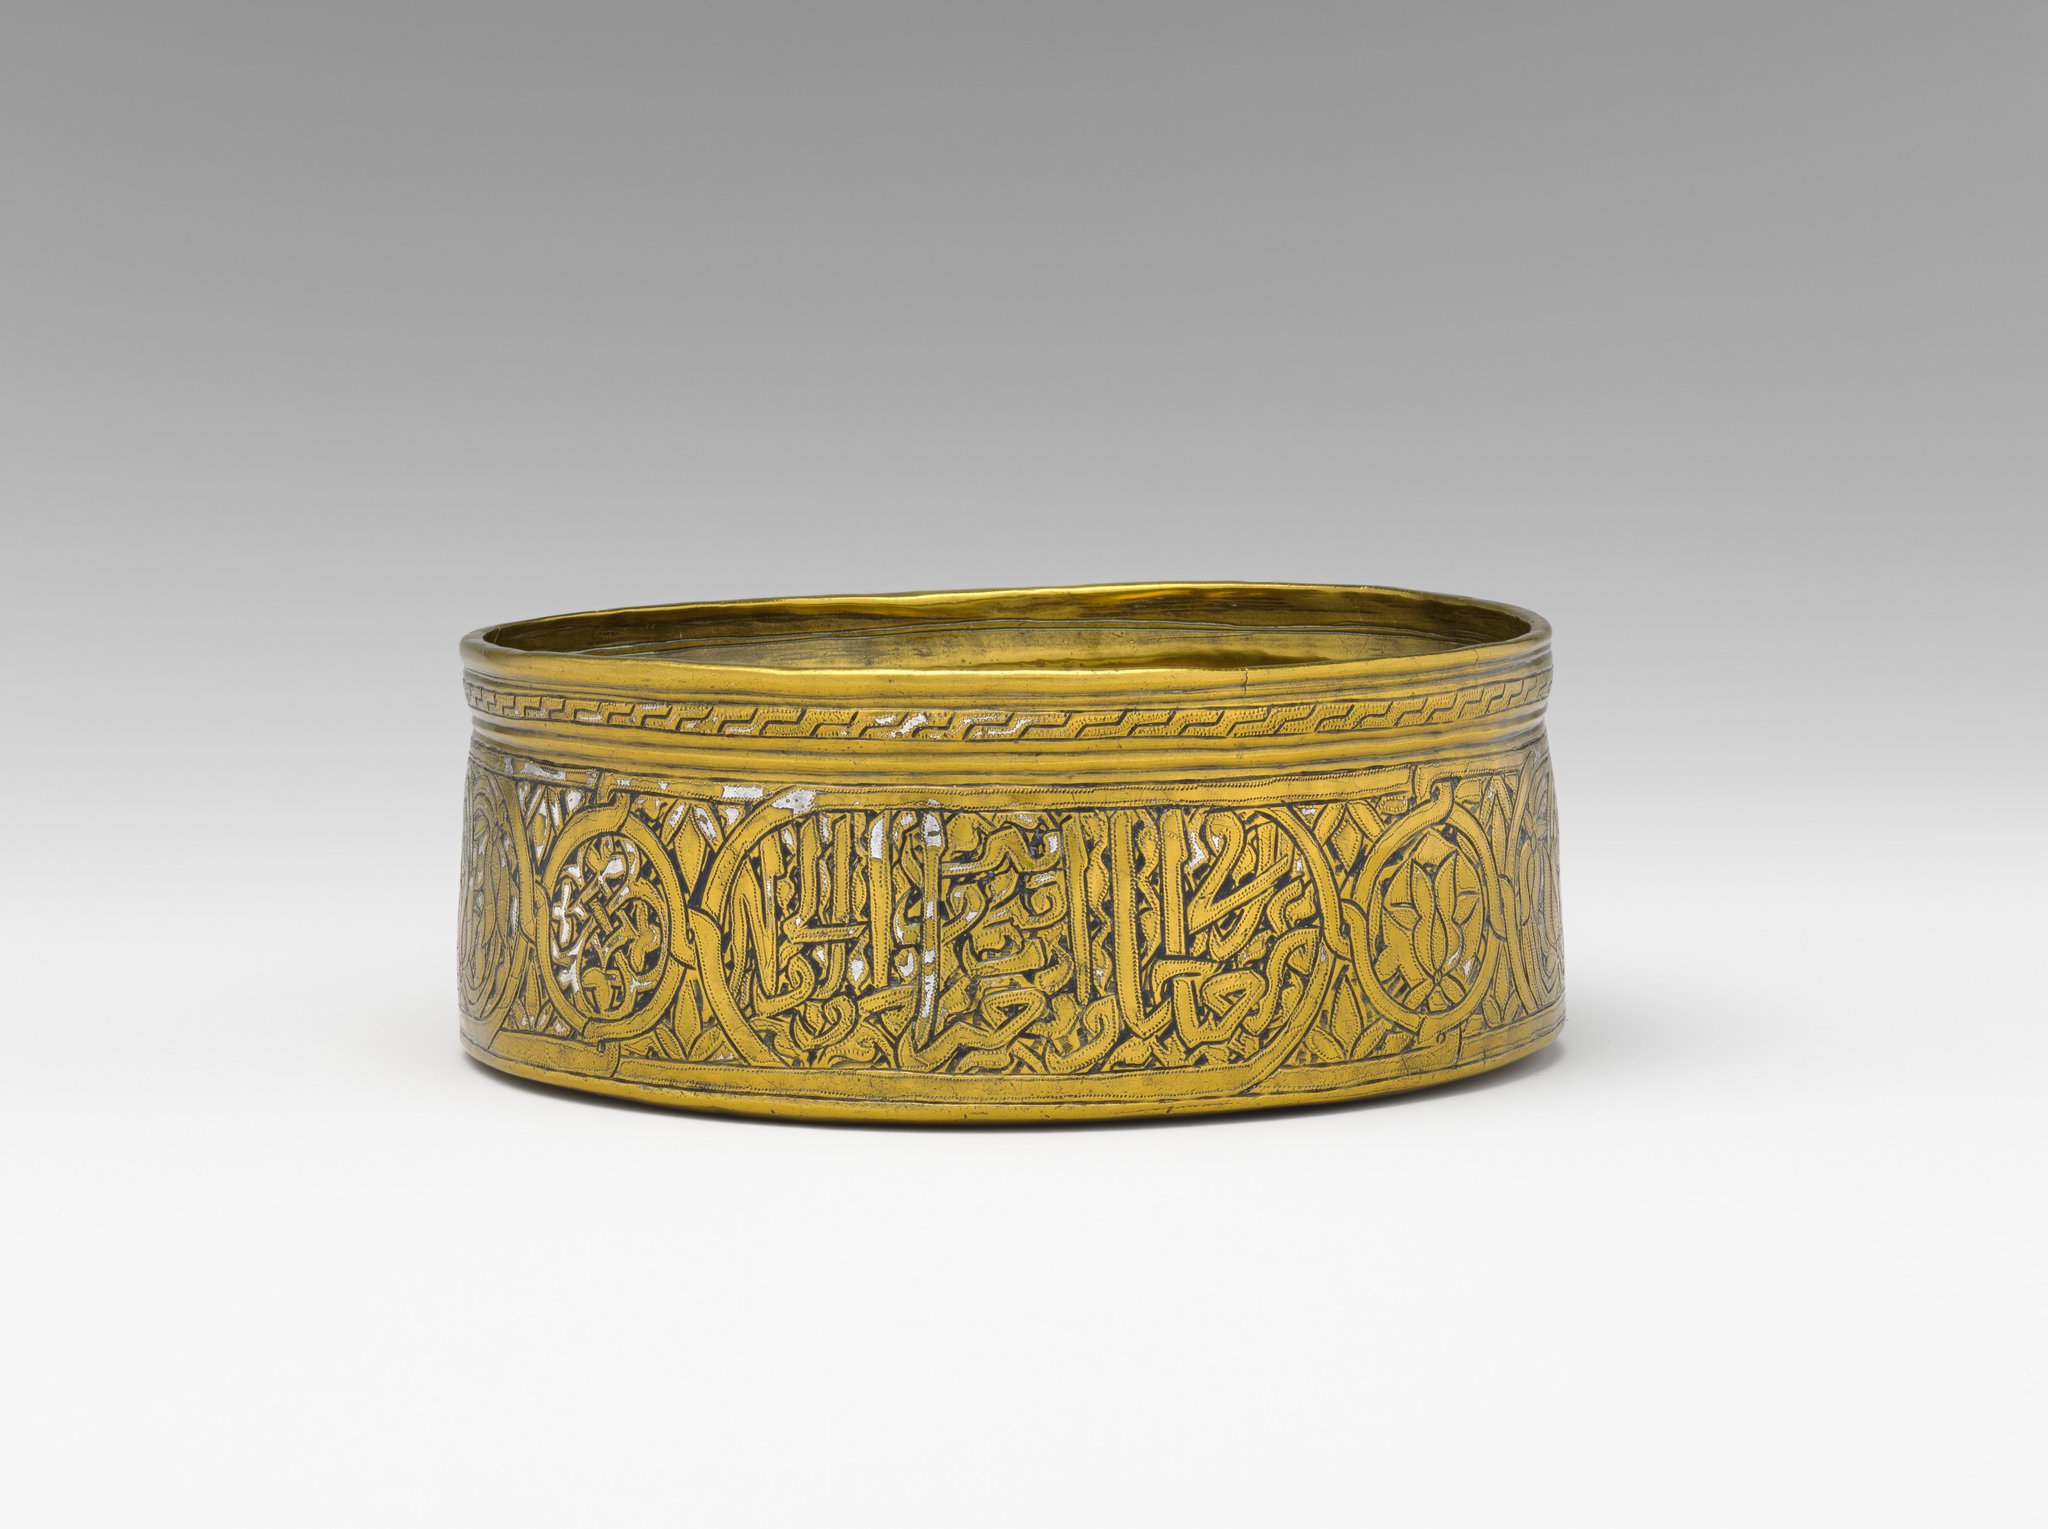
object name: box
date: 1351-1400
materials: brass, silver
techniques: engraving, inlay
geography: egypt or syria